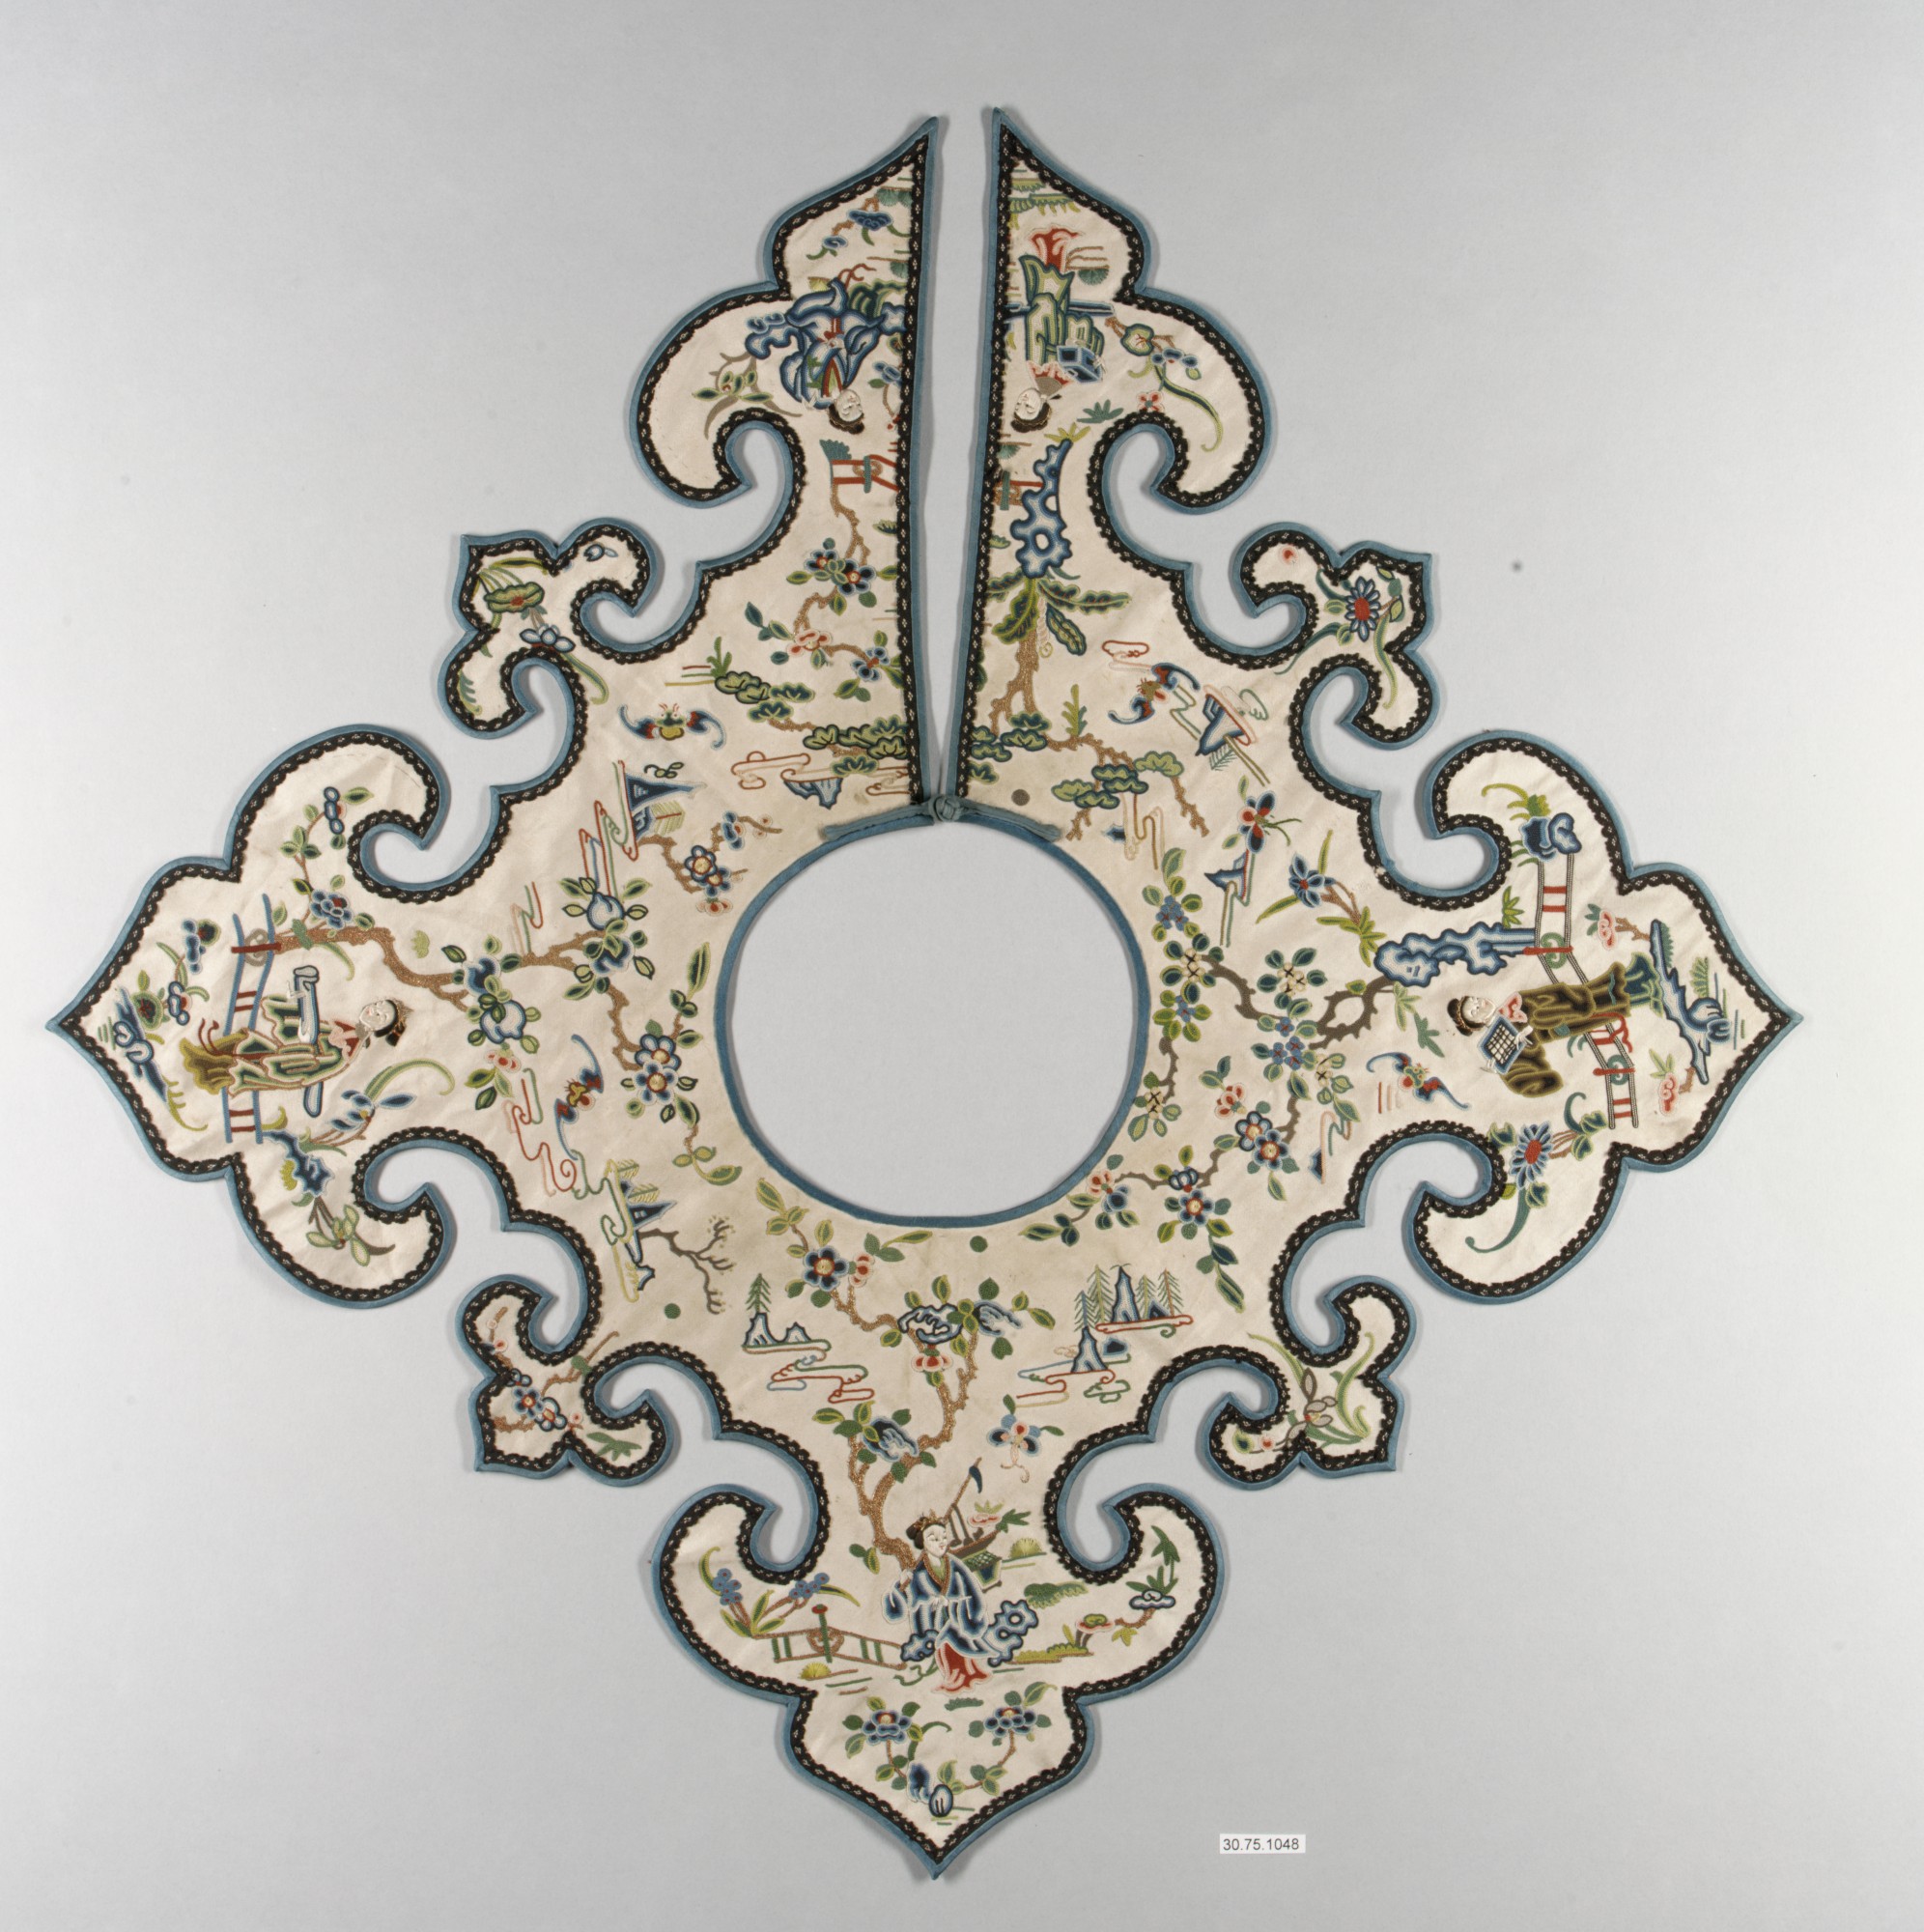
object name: collar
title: Collar with Design of Ruyi-Head Scepters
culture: chinese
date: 1644-1911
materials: metal thread, silk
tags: human figures